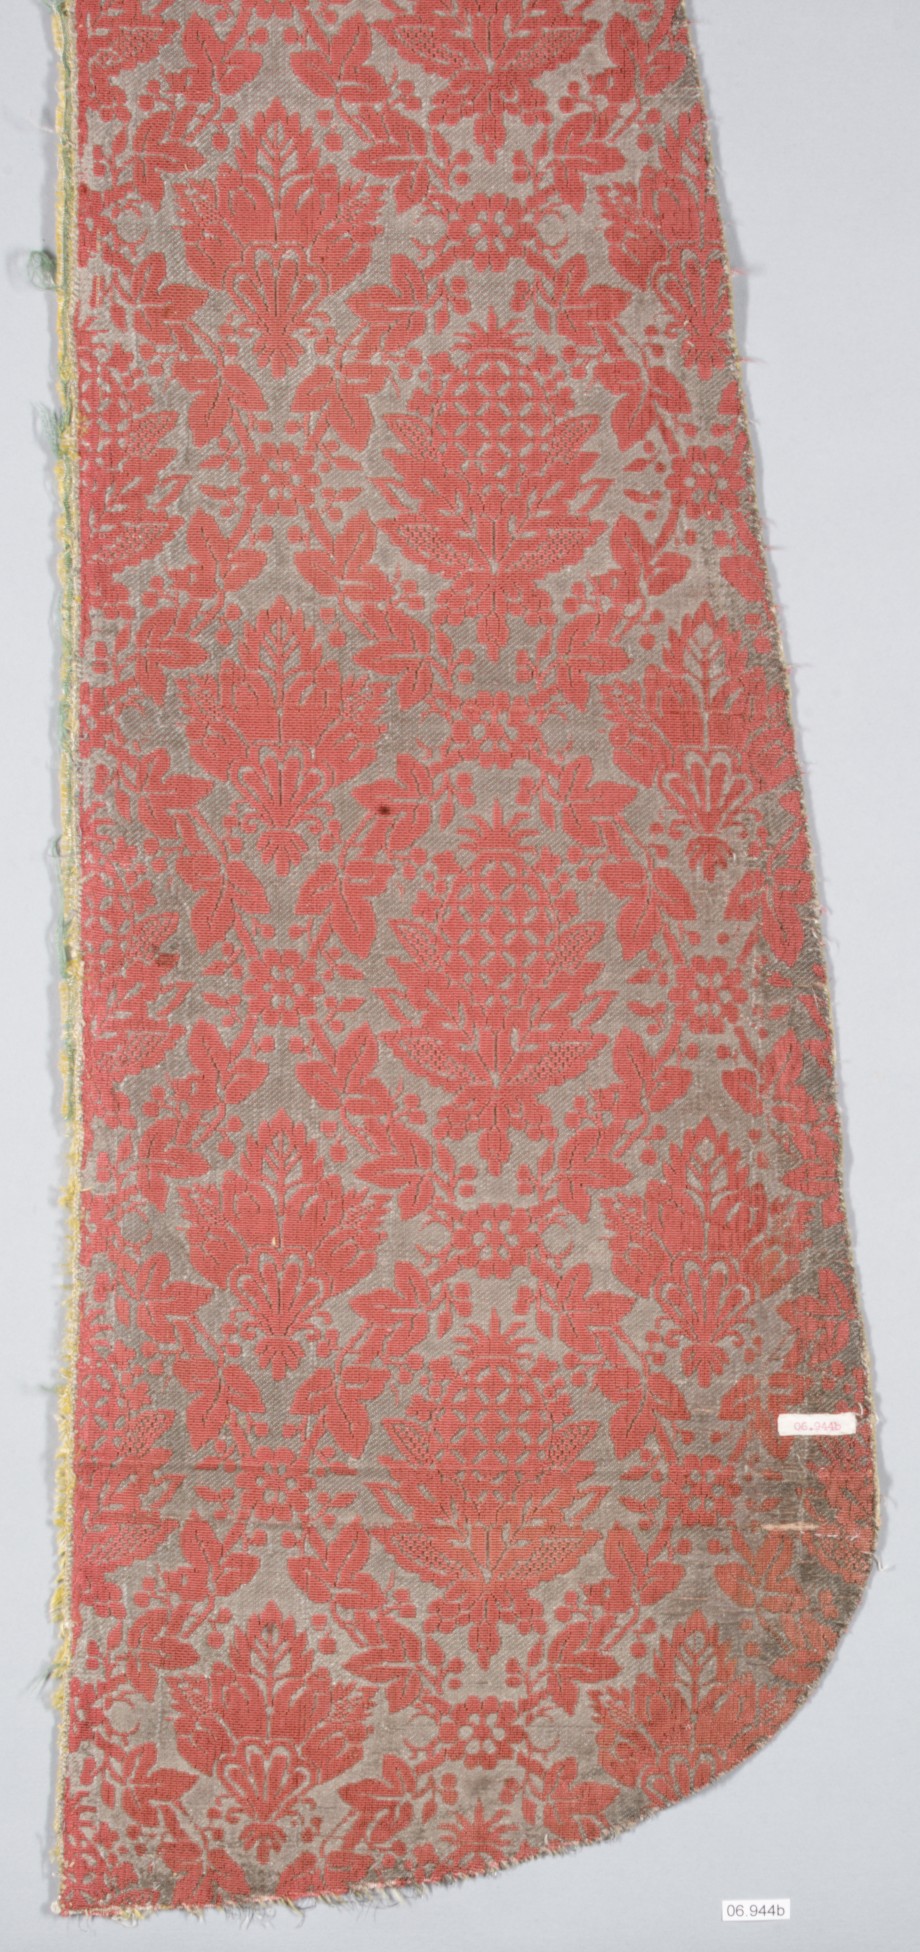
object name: piece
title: Pieces (2)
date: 1601-1700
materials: metal thread, silk